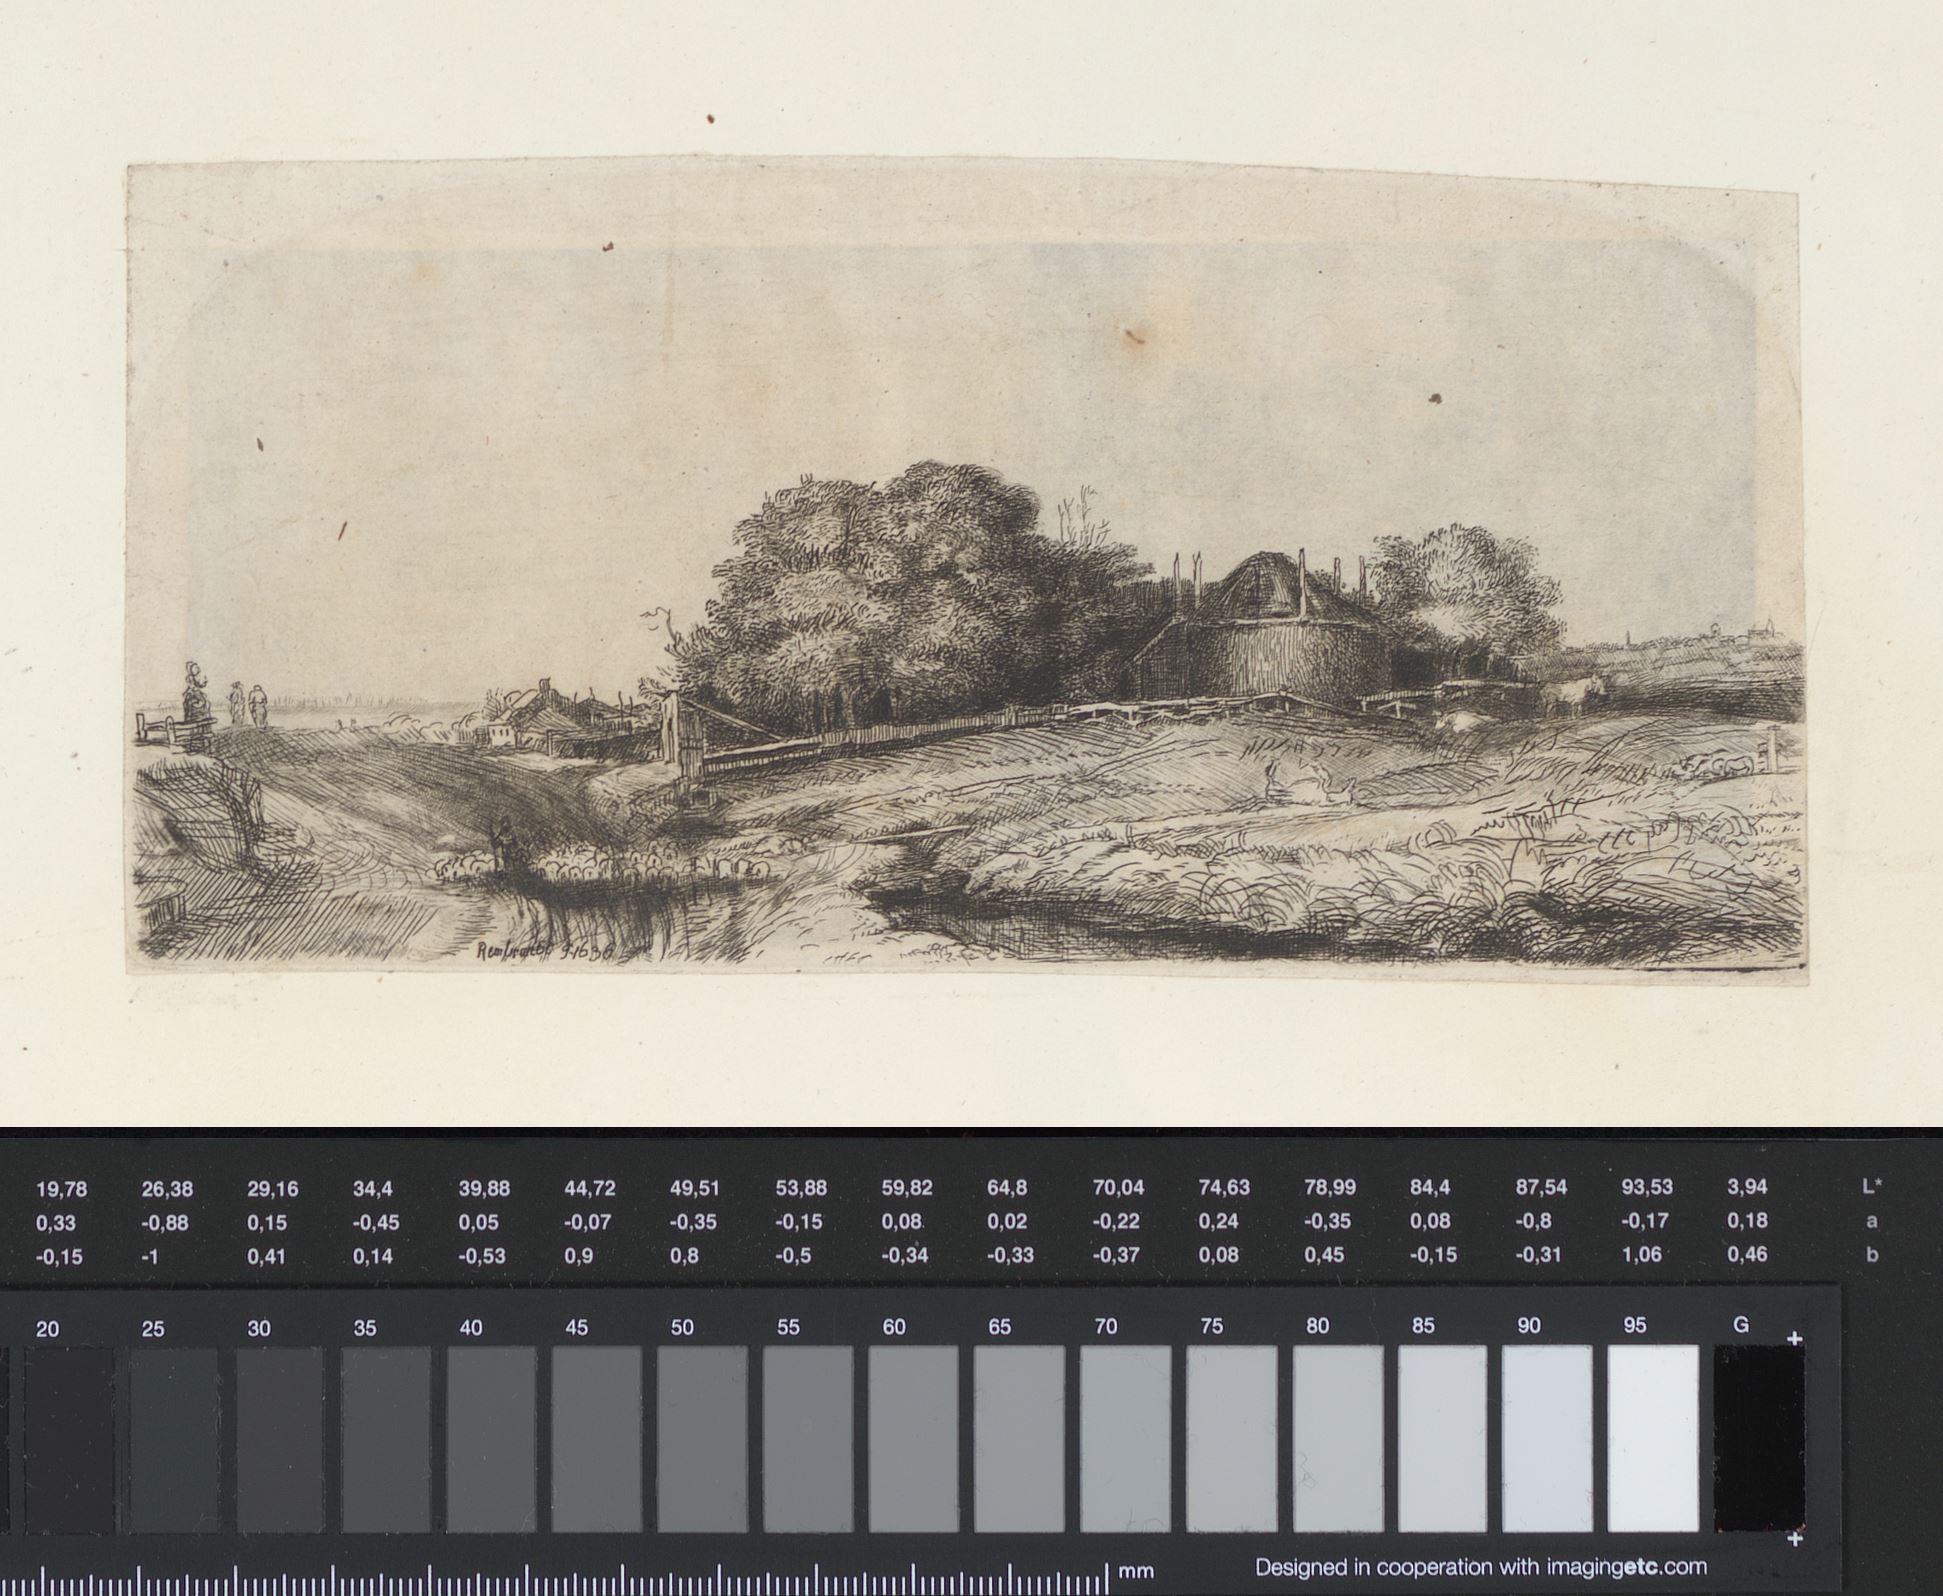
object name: album leaf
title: Landschap met hooischuur en kudde schapen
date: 1753-1810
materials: paper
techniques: drypoint, etching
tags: city-view, and landscape with man-made constructions